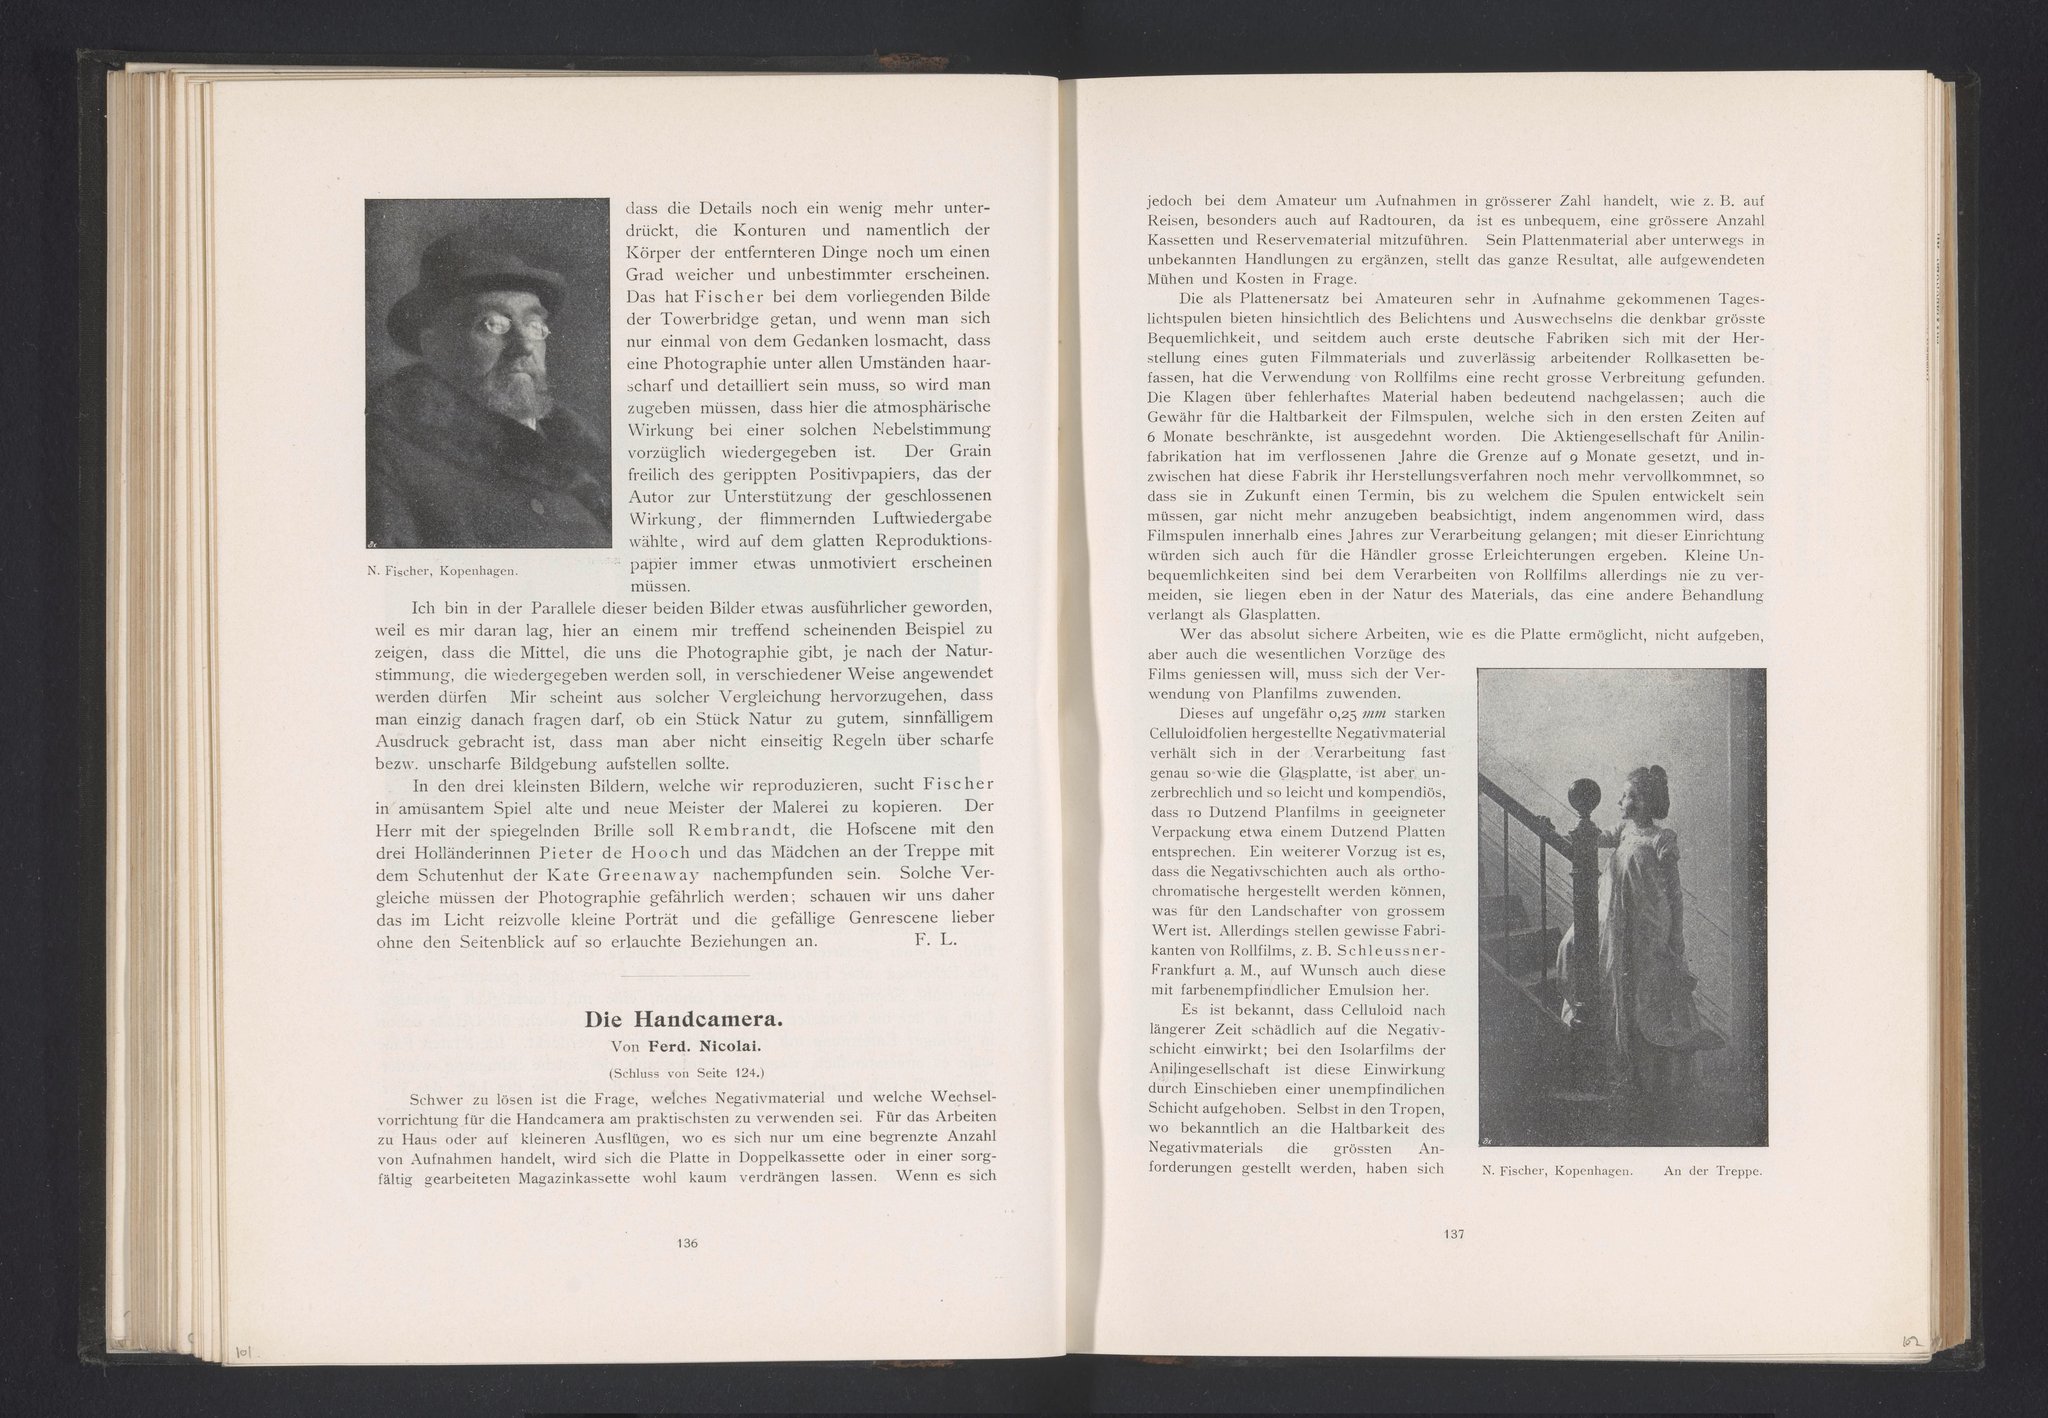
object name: page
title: Portret van een onbekend meisje bij een trap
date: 1898-1903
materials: paper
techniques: autotype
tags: historical persons - bb - woman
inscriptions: monogram: ‘BX’, inscription: ‘Kopenhagen’